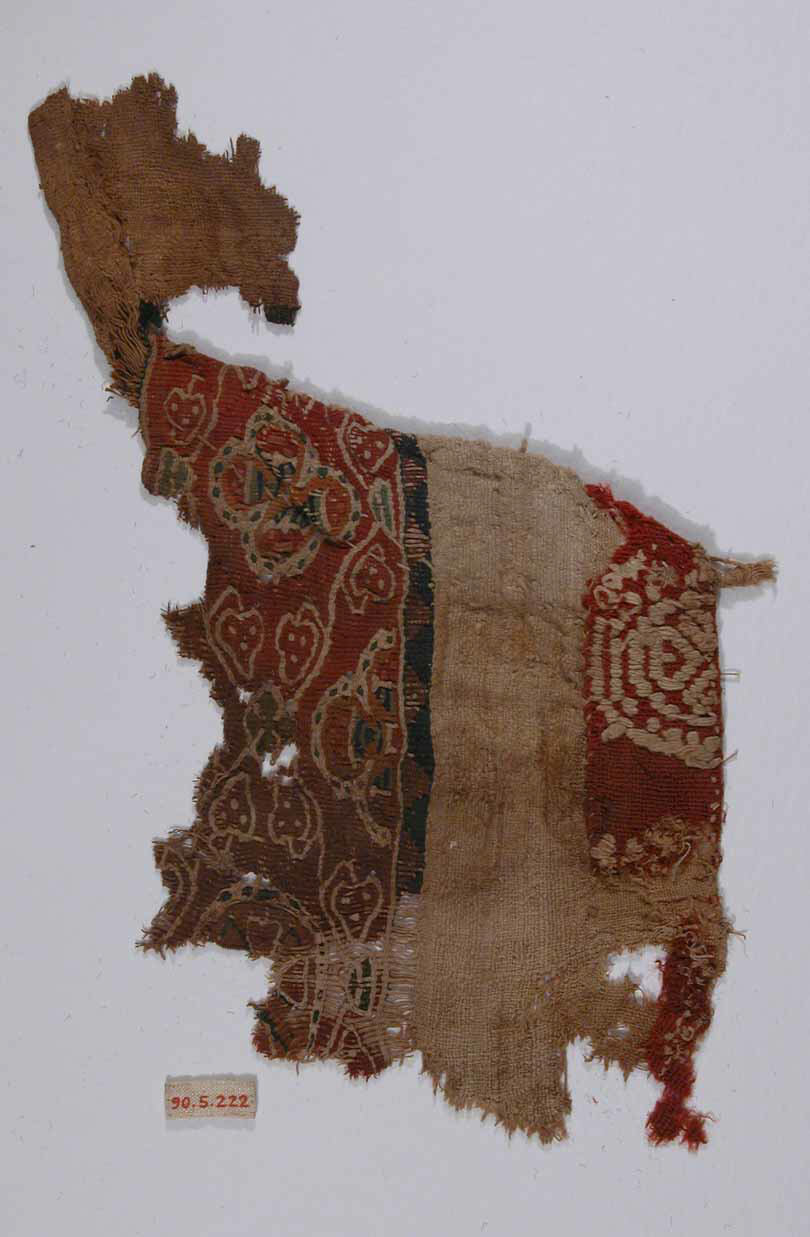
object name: textile fragment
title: Fragment of a Sleeve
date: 401-600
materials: linen, wool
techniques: weave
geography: egypt